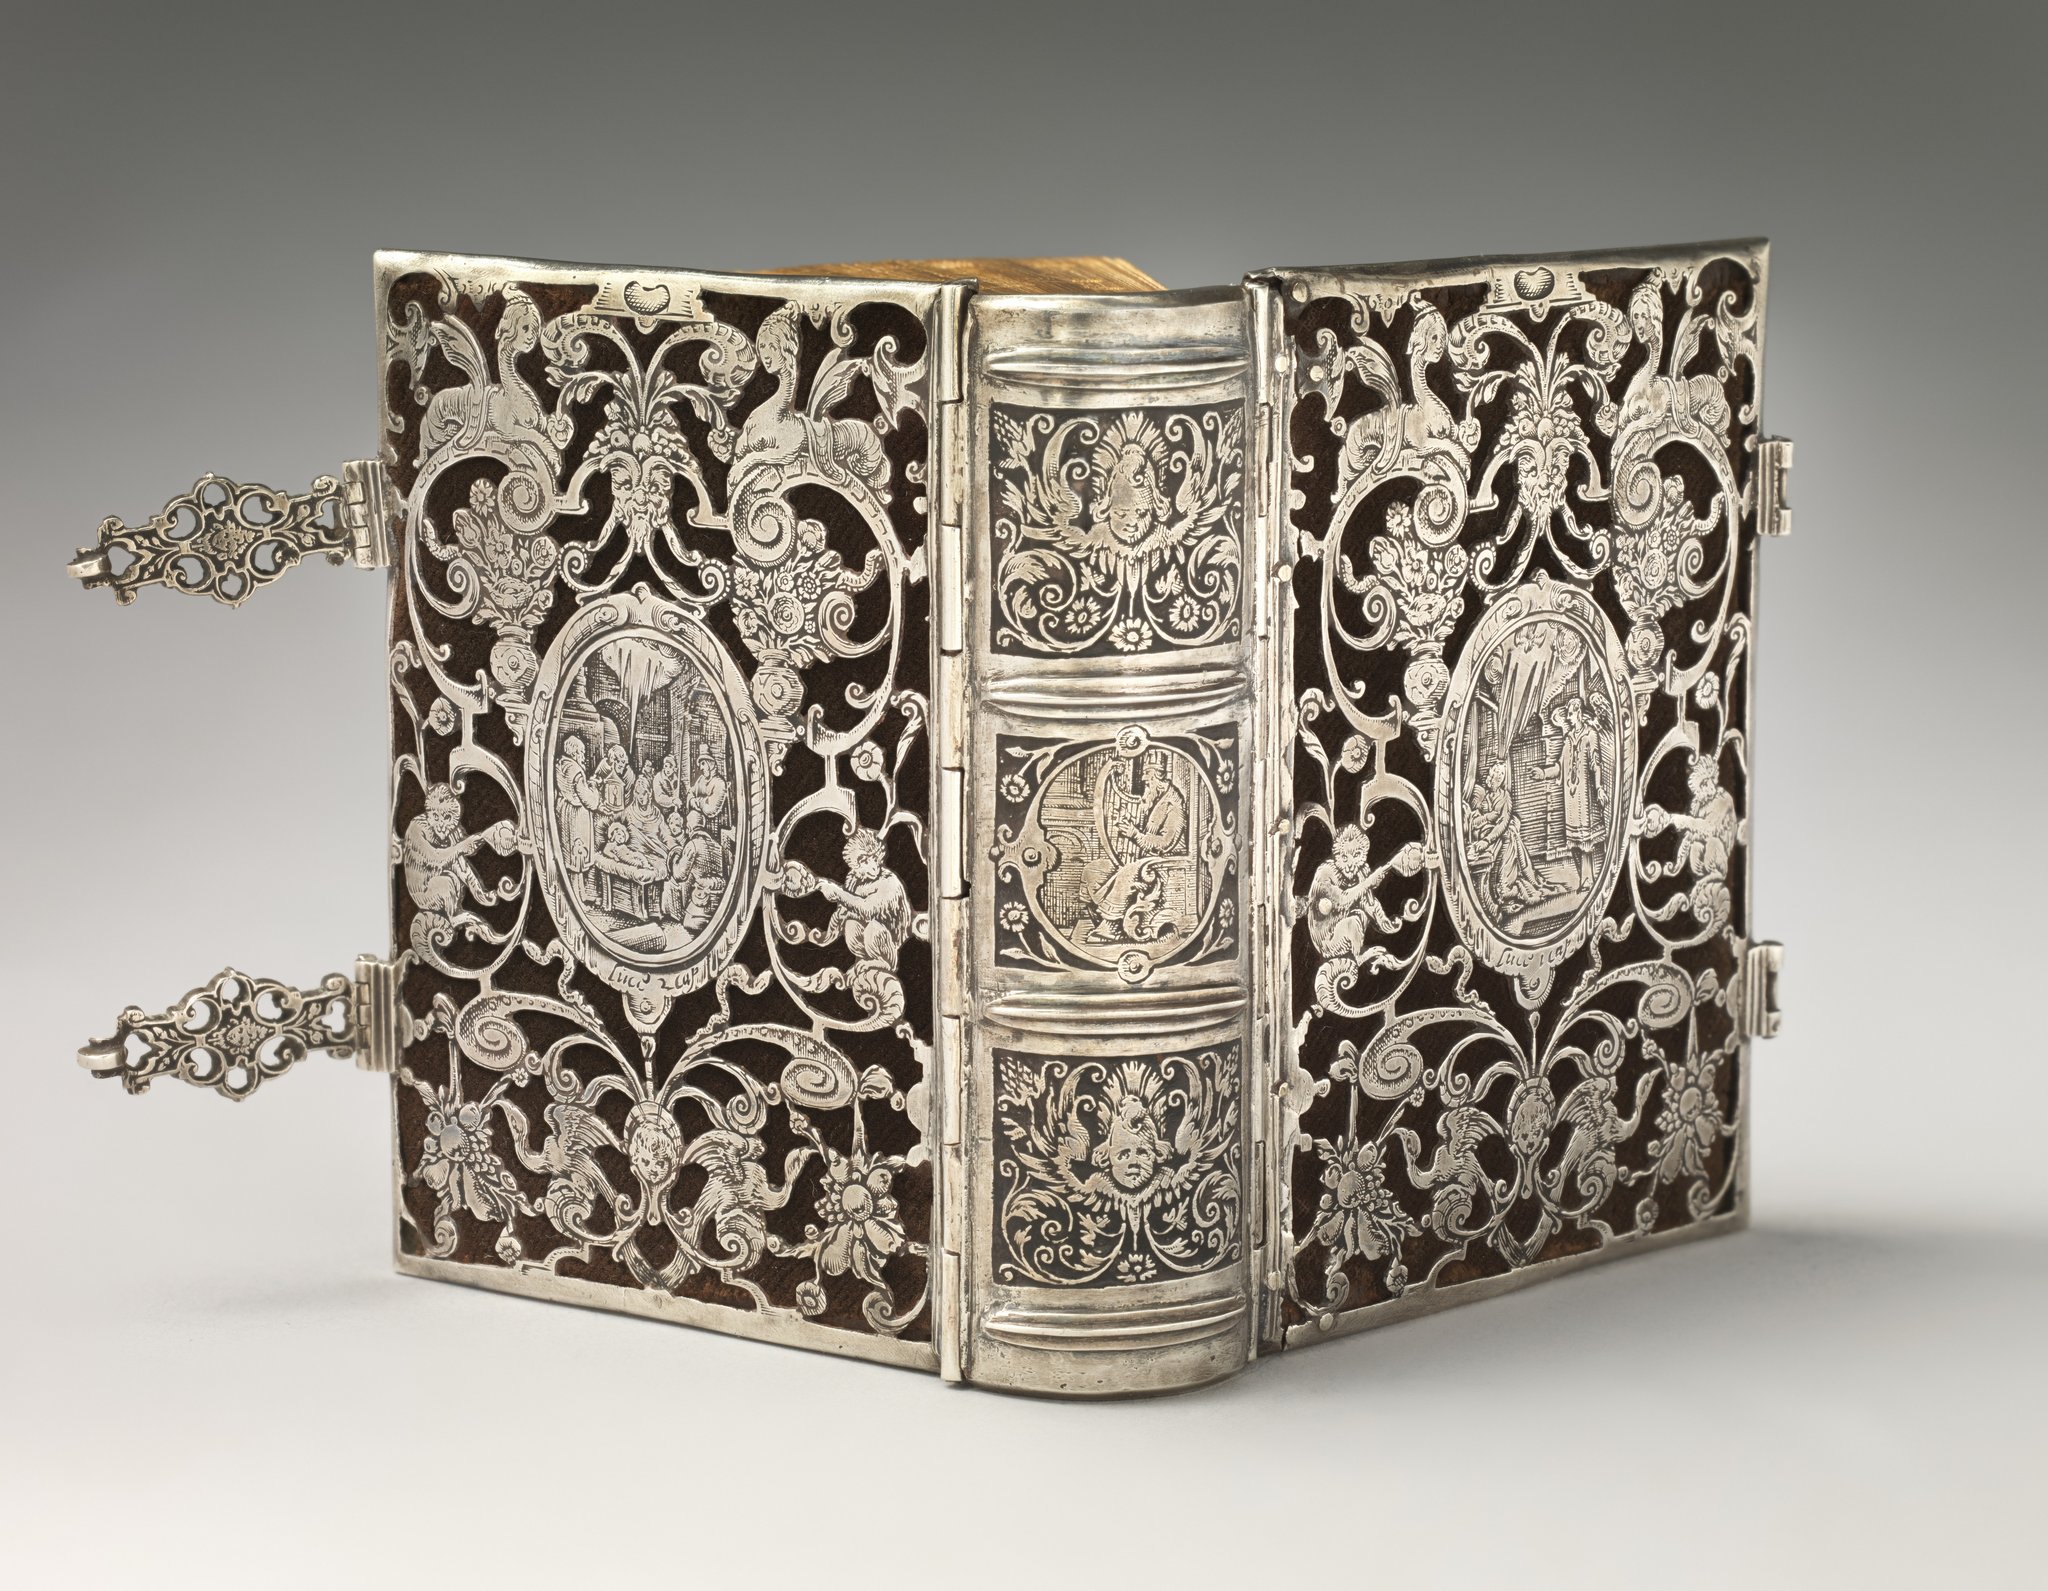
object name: book cover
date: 1610-1620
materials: silver, velvet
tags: sphinx,monkeys,adoration of the shepherds,annunciation